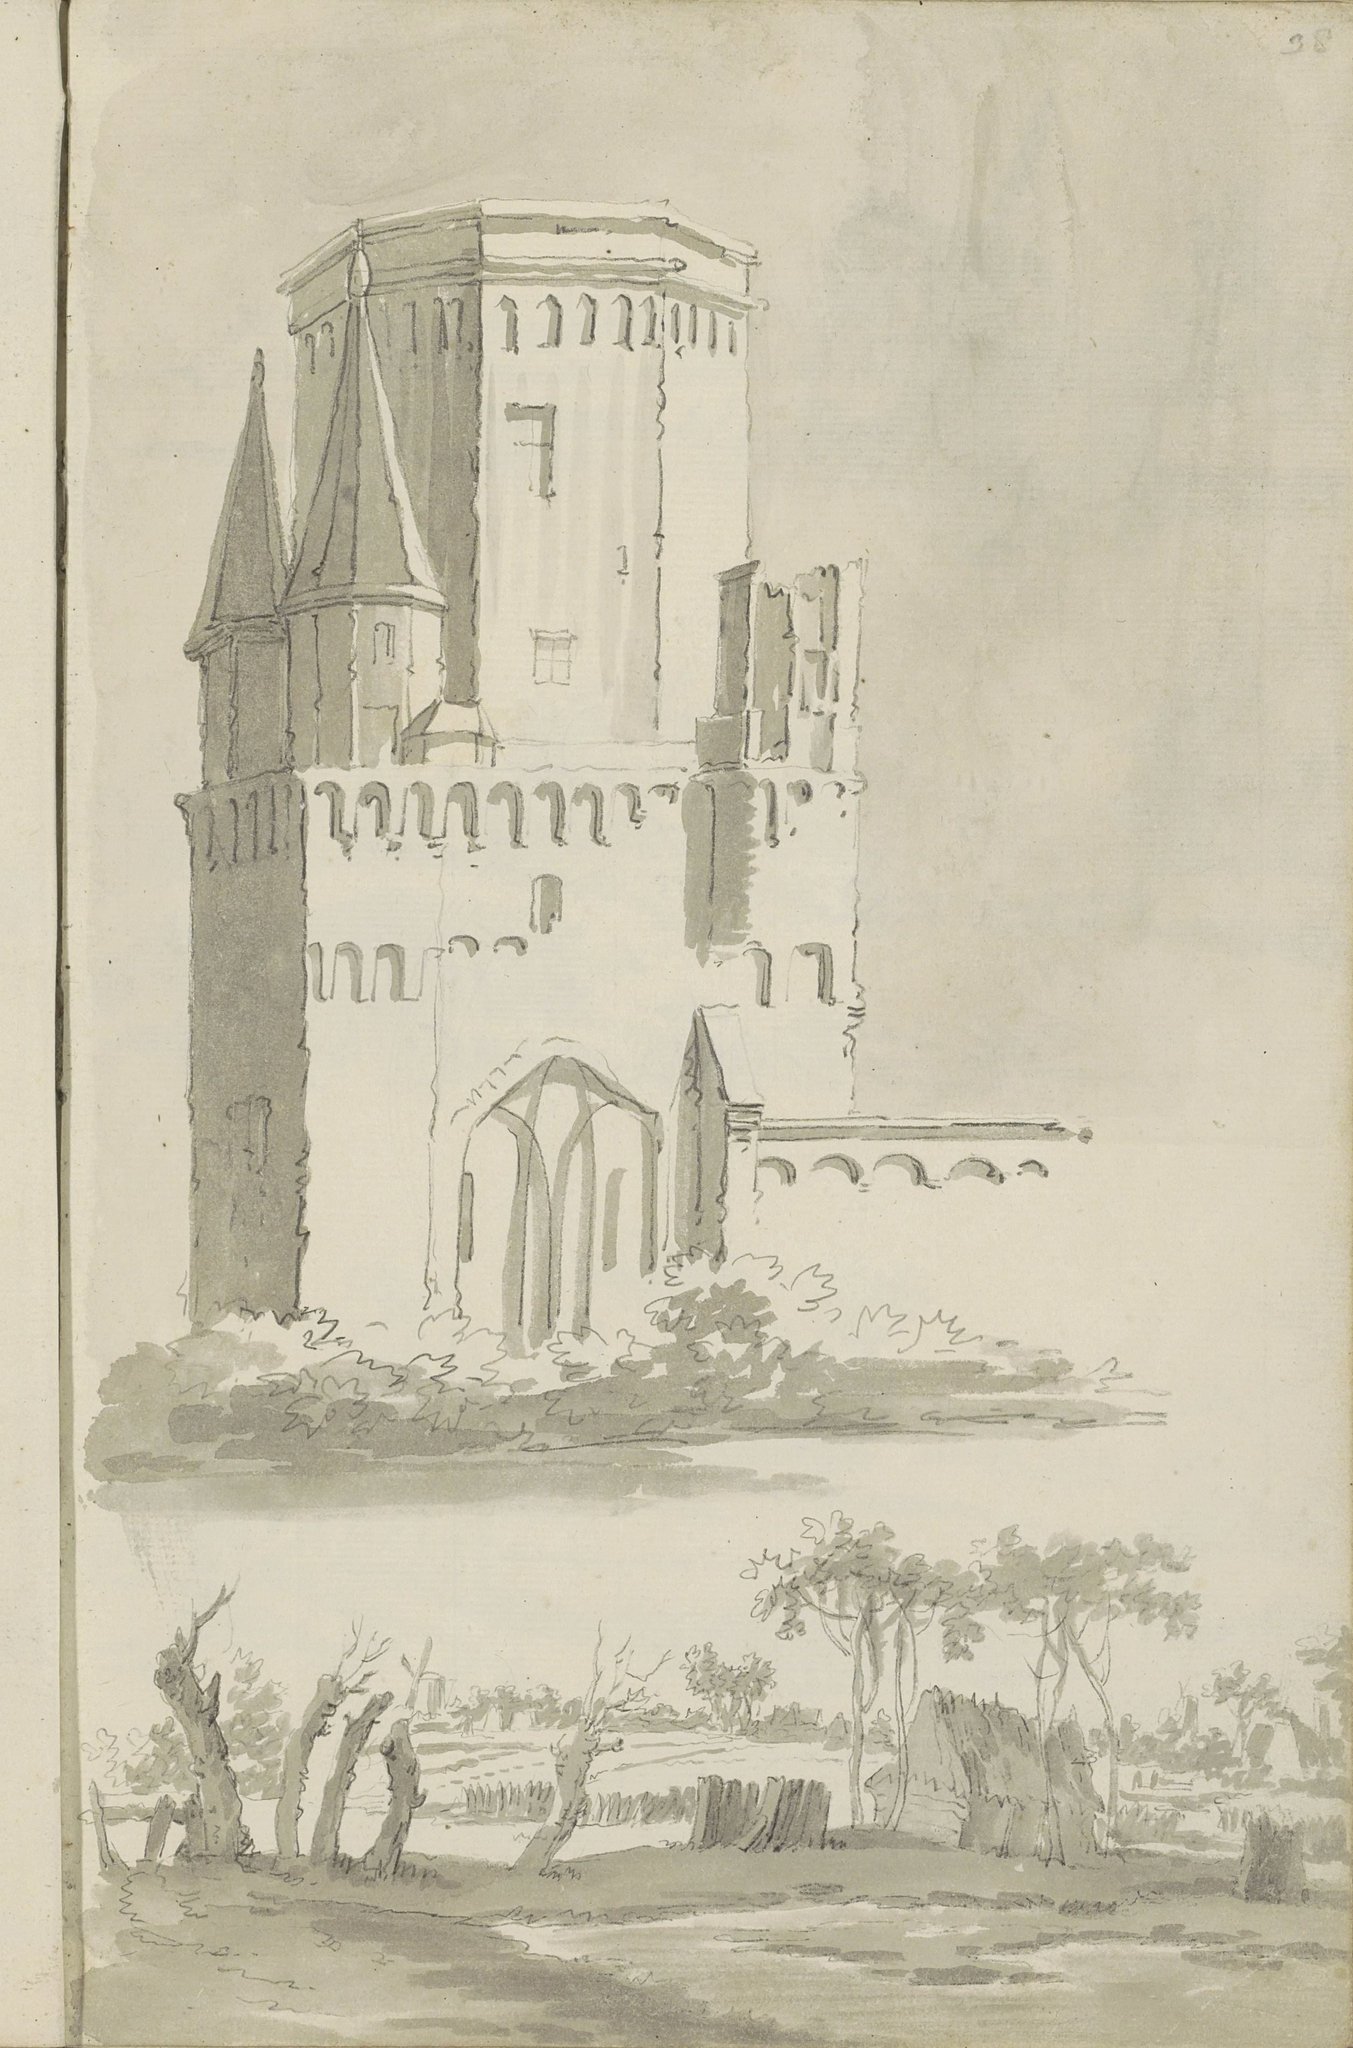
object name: sketchbook leaf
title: Exterieur van een kerk en een landschap met hut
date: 1780-1800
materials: paper, pencil, watercolor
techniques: brush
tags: church (exterior), hut, cabin, lodge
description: Blad 15 recto uit een schetsboek met 25 bladen.